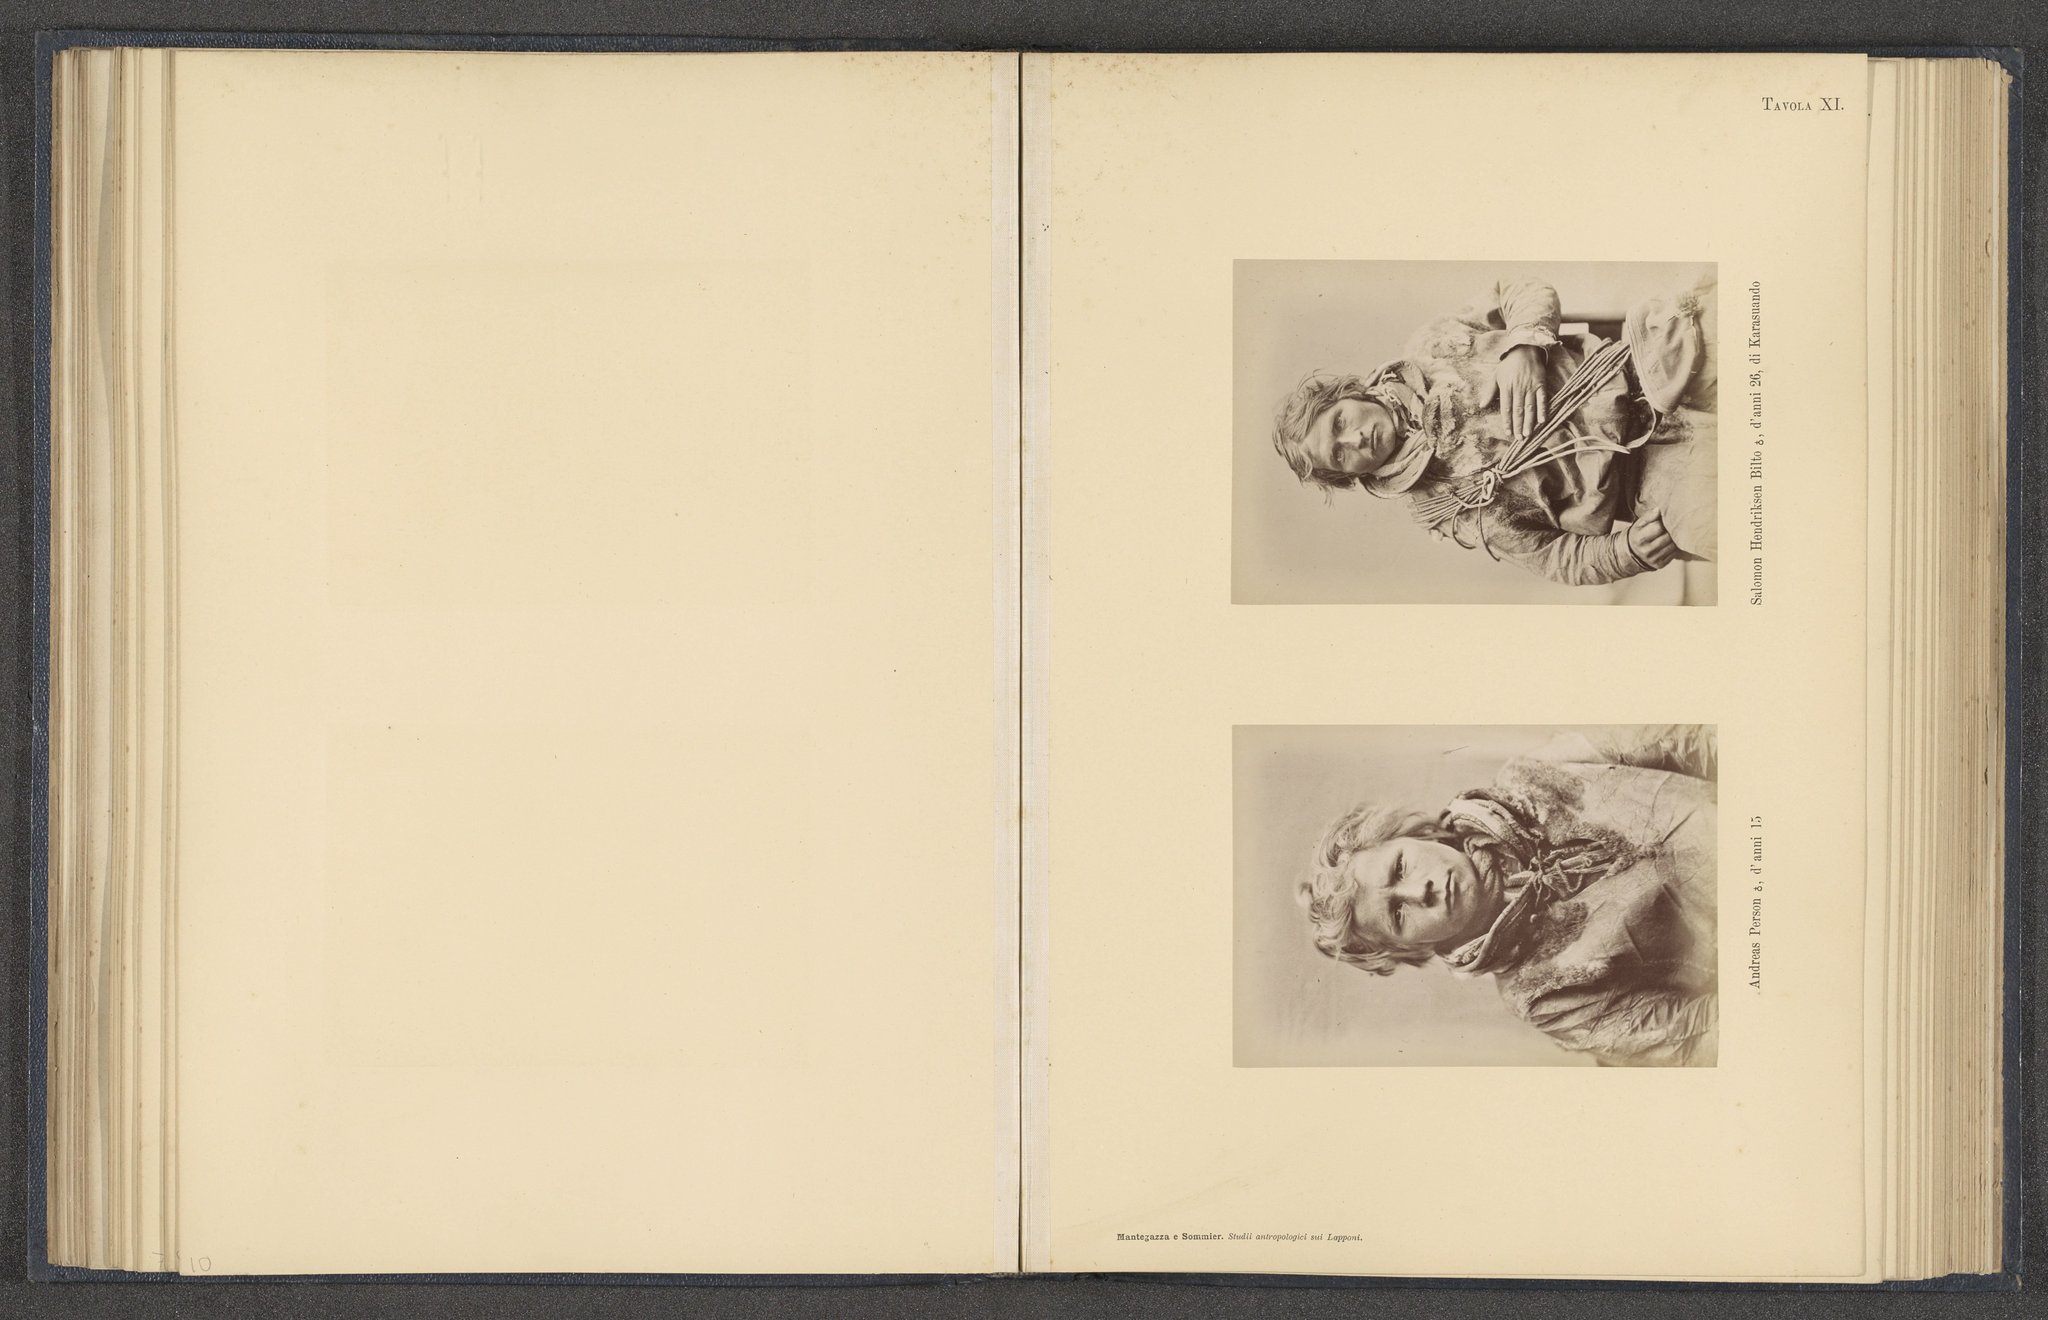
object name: page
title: Twee portretten van Andreas Person en Solomon Hendriksen Bilto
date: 1870-1880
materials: paper, photographic support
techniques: albumen print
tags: adult man (+ front view), fashion, clothing (+ fur used for clothes)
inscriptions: number: ‘Tavola XI.’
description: Links een vooraanzicht van Andreas Person, rechts een vooraanzicht van Solomon Hendriksen Bilto.